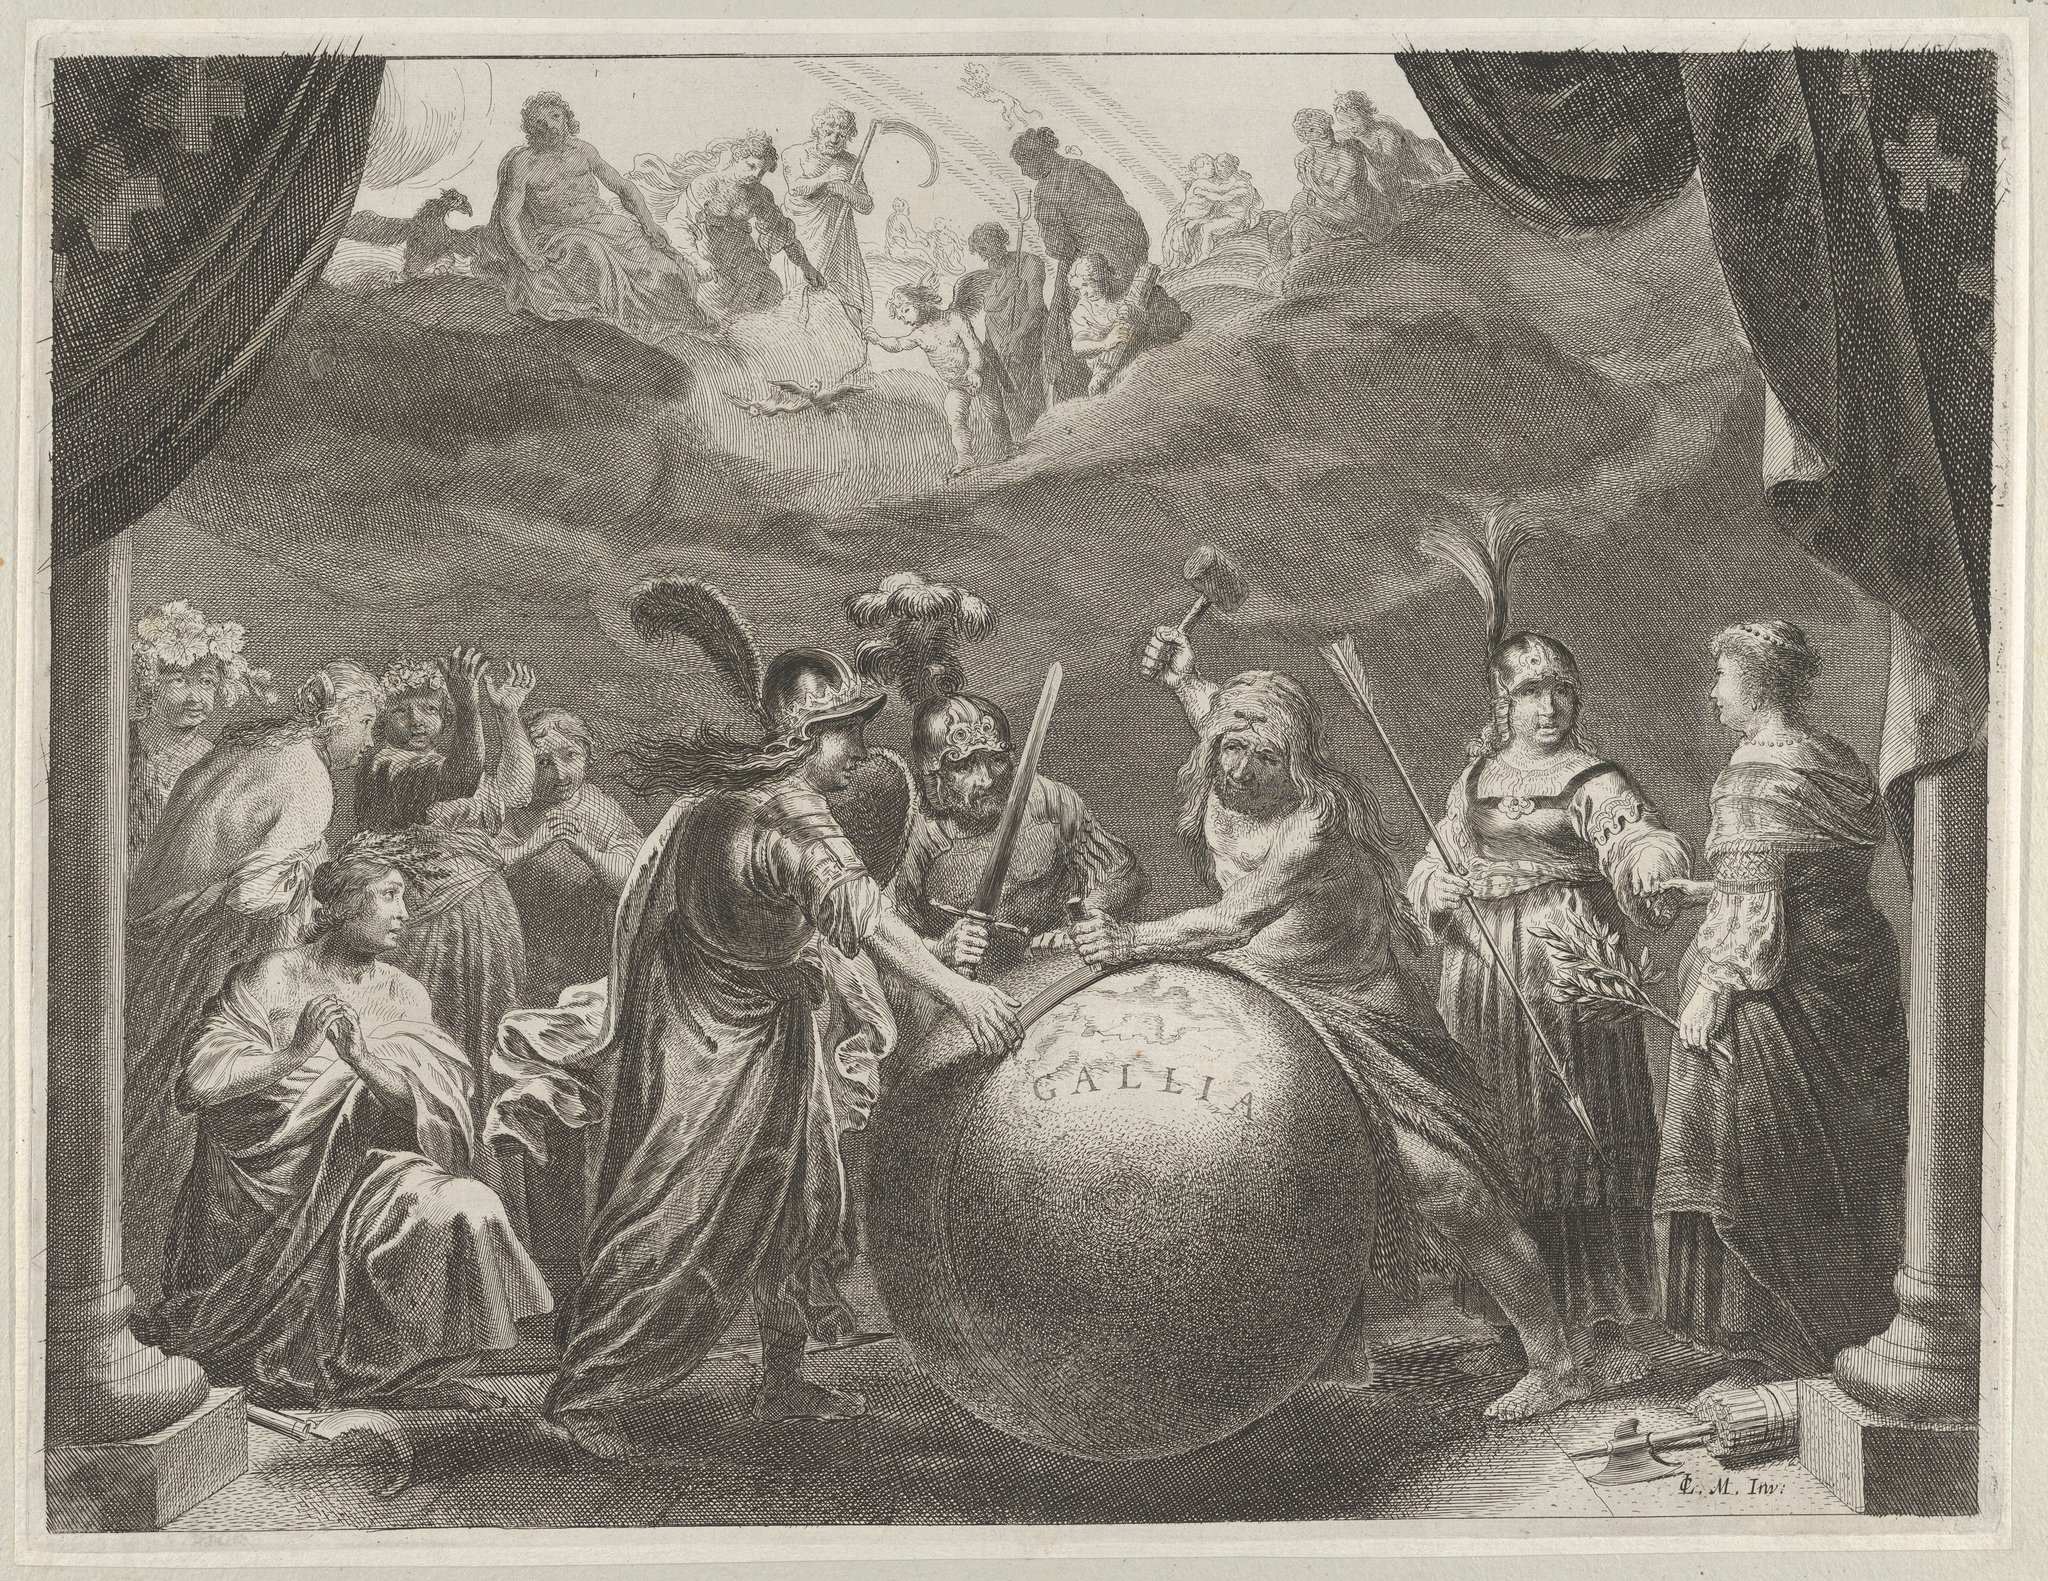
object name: print, fete, ornament architecture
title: Plate 12: Allegory on the Discord in France, from Caspar Barlaeus, "Medicea Hospes"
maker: pieter nolpe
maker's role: artist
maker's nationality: dutch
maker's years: 1613-1614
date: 1638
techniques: etching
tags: men,women,globes